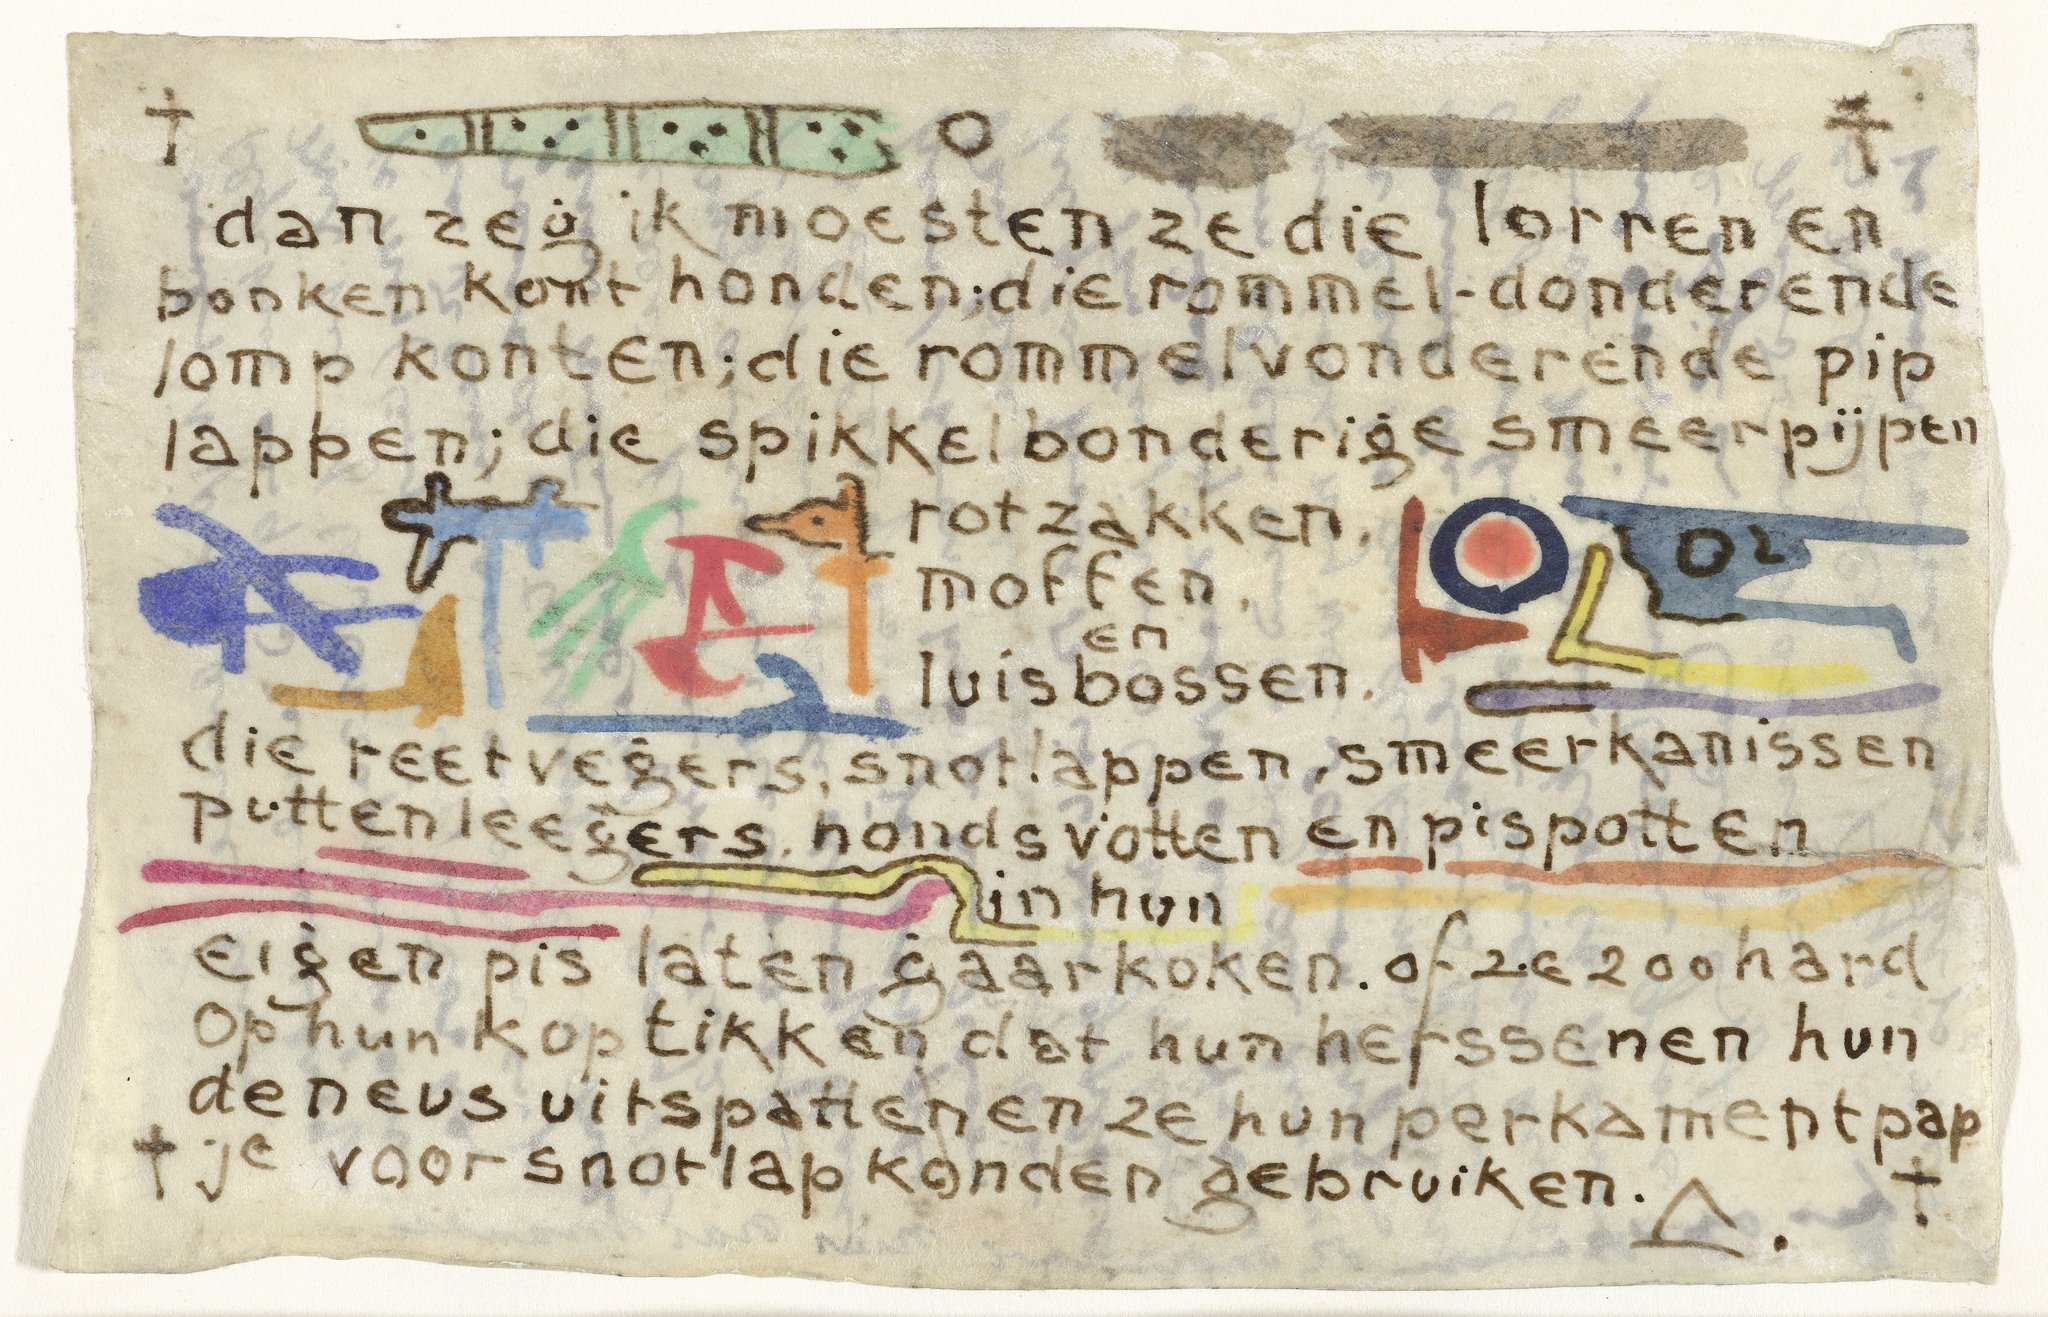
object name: drawing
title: Brief met kalligrafie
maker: gerrit willem dijsselhof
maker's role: designer, draughtsman, print maker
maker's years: 1866-1924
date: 1876-1924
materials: ink, parchment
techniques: brush, pen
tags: handwriting, written text